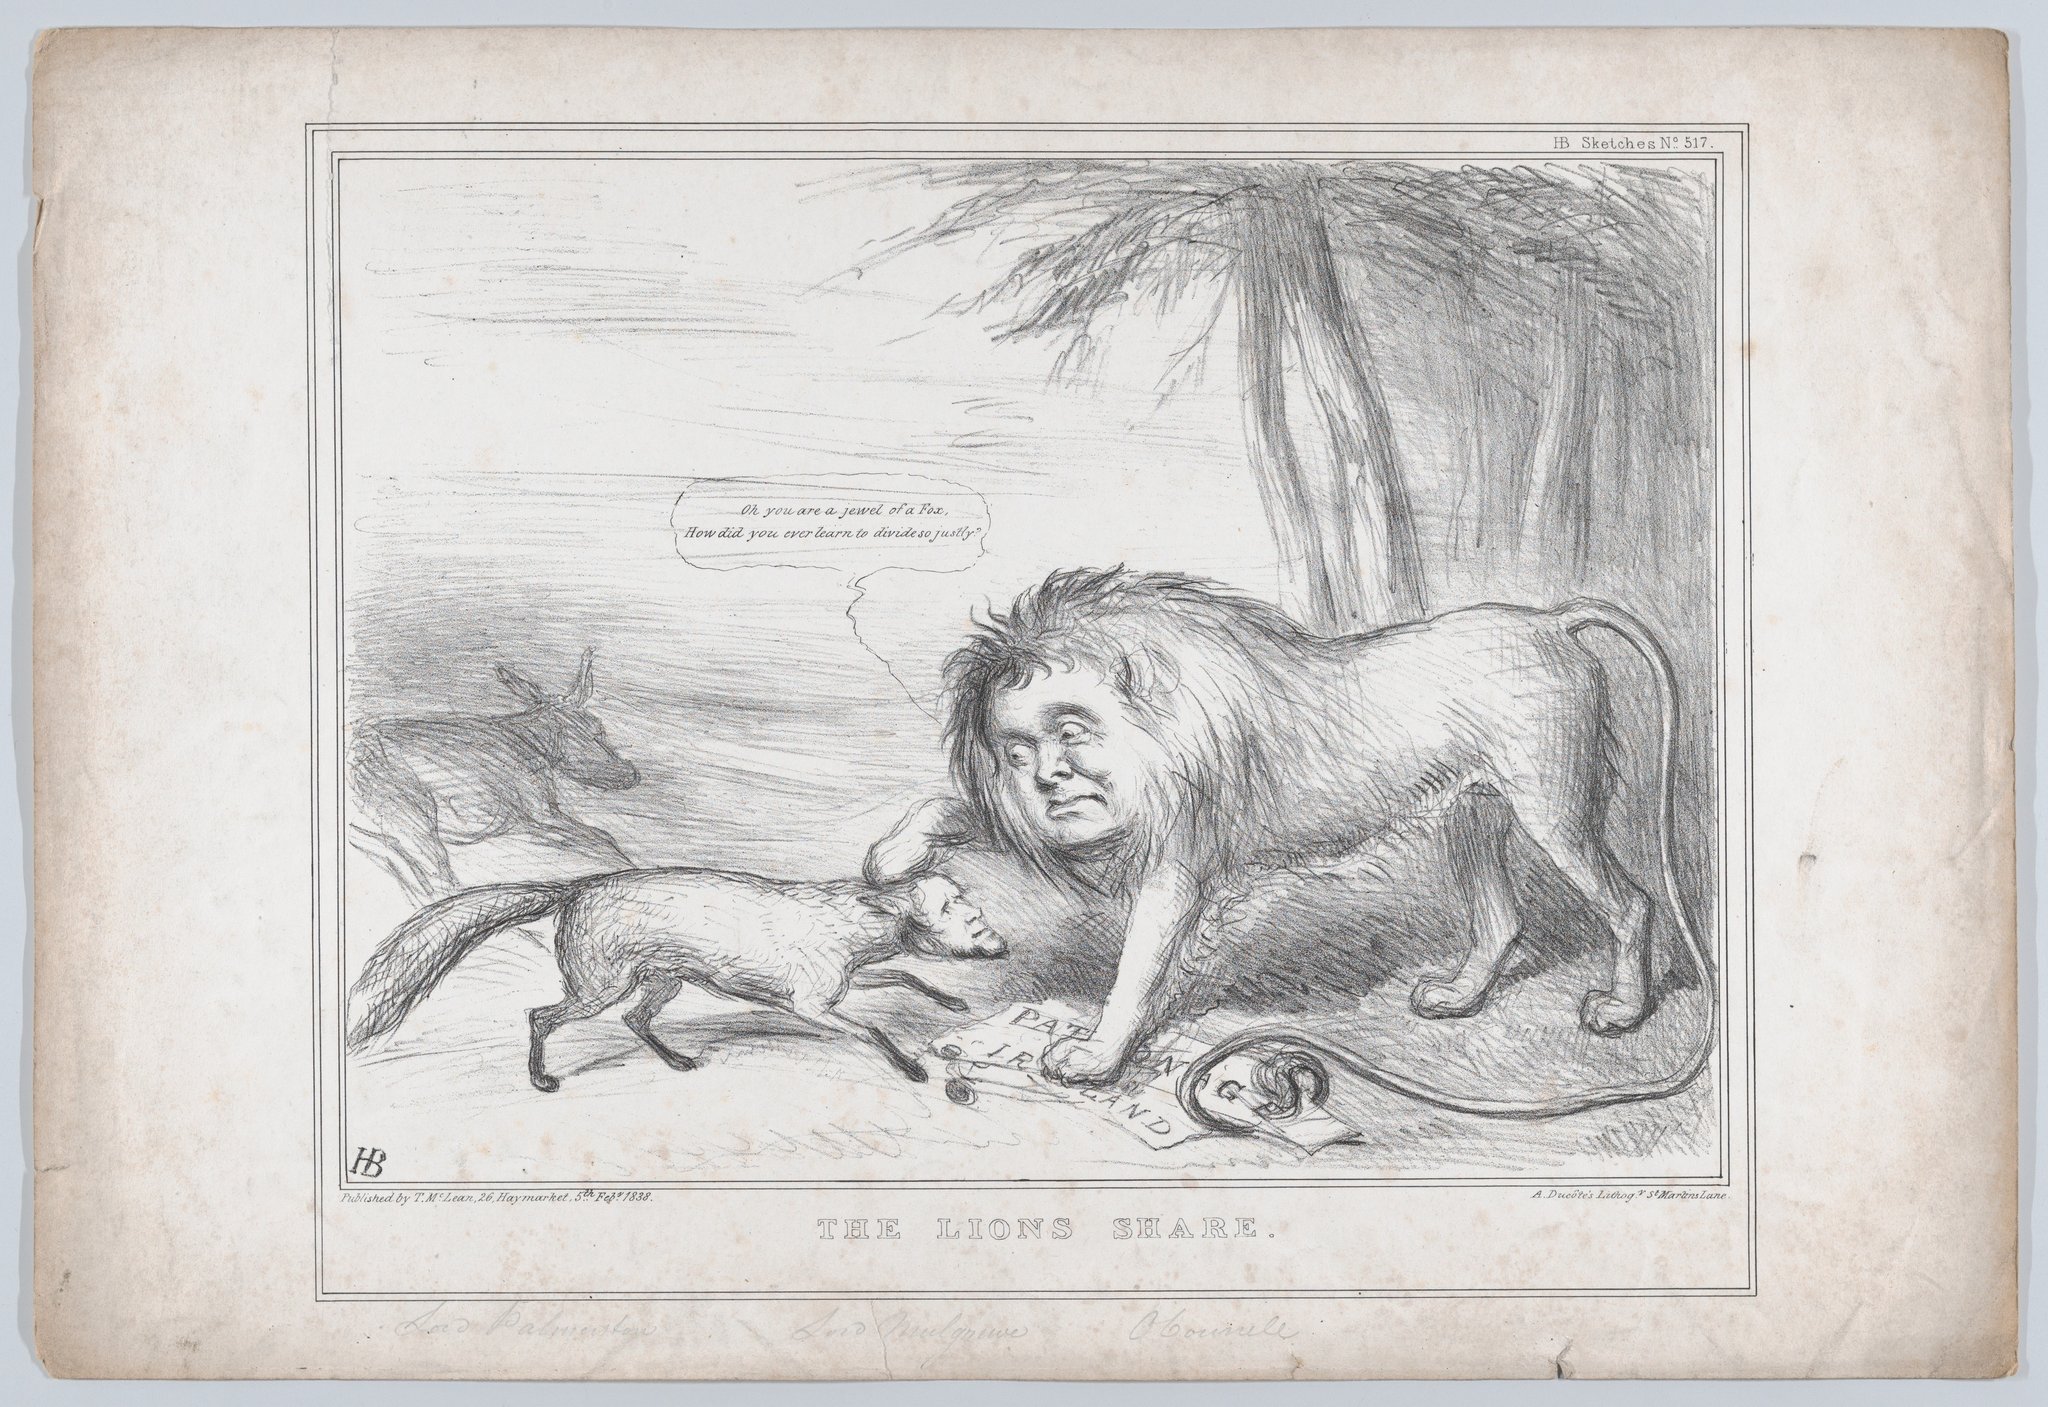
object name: print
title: The Lion's Share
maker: john doyle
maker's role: artist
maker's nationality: irish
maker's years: 1797-1868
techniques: lithograph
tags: donkeys,lions,caricature